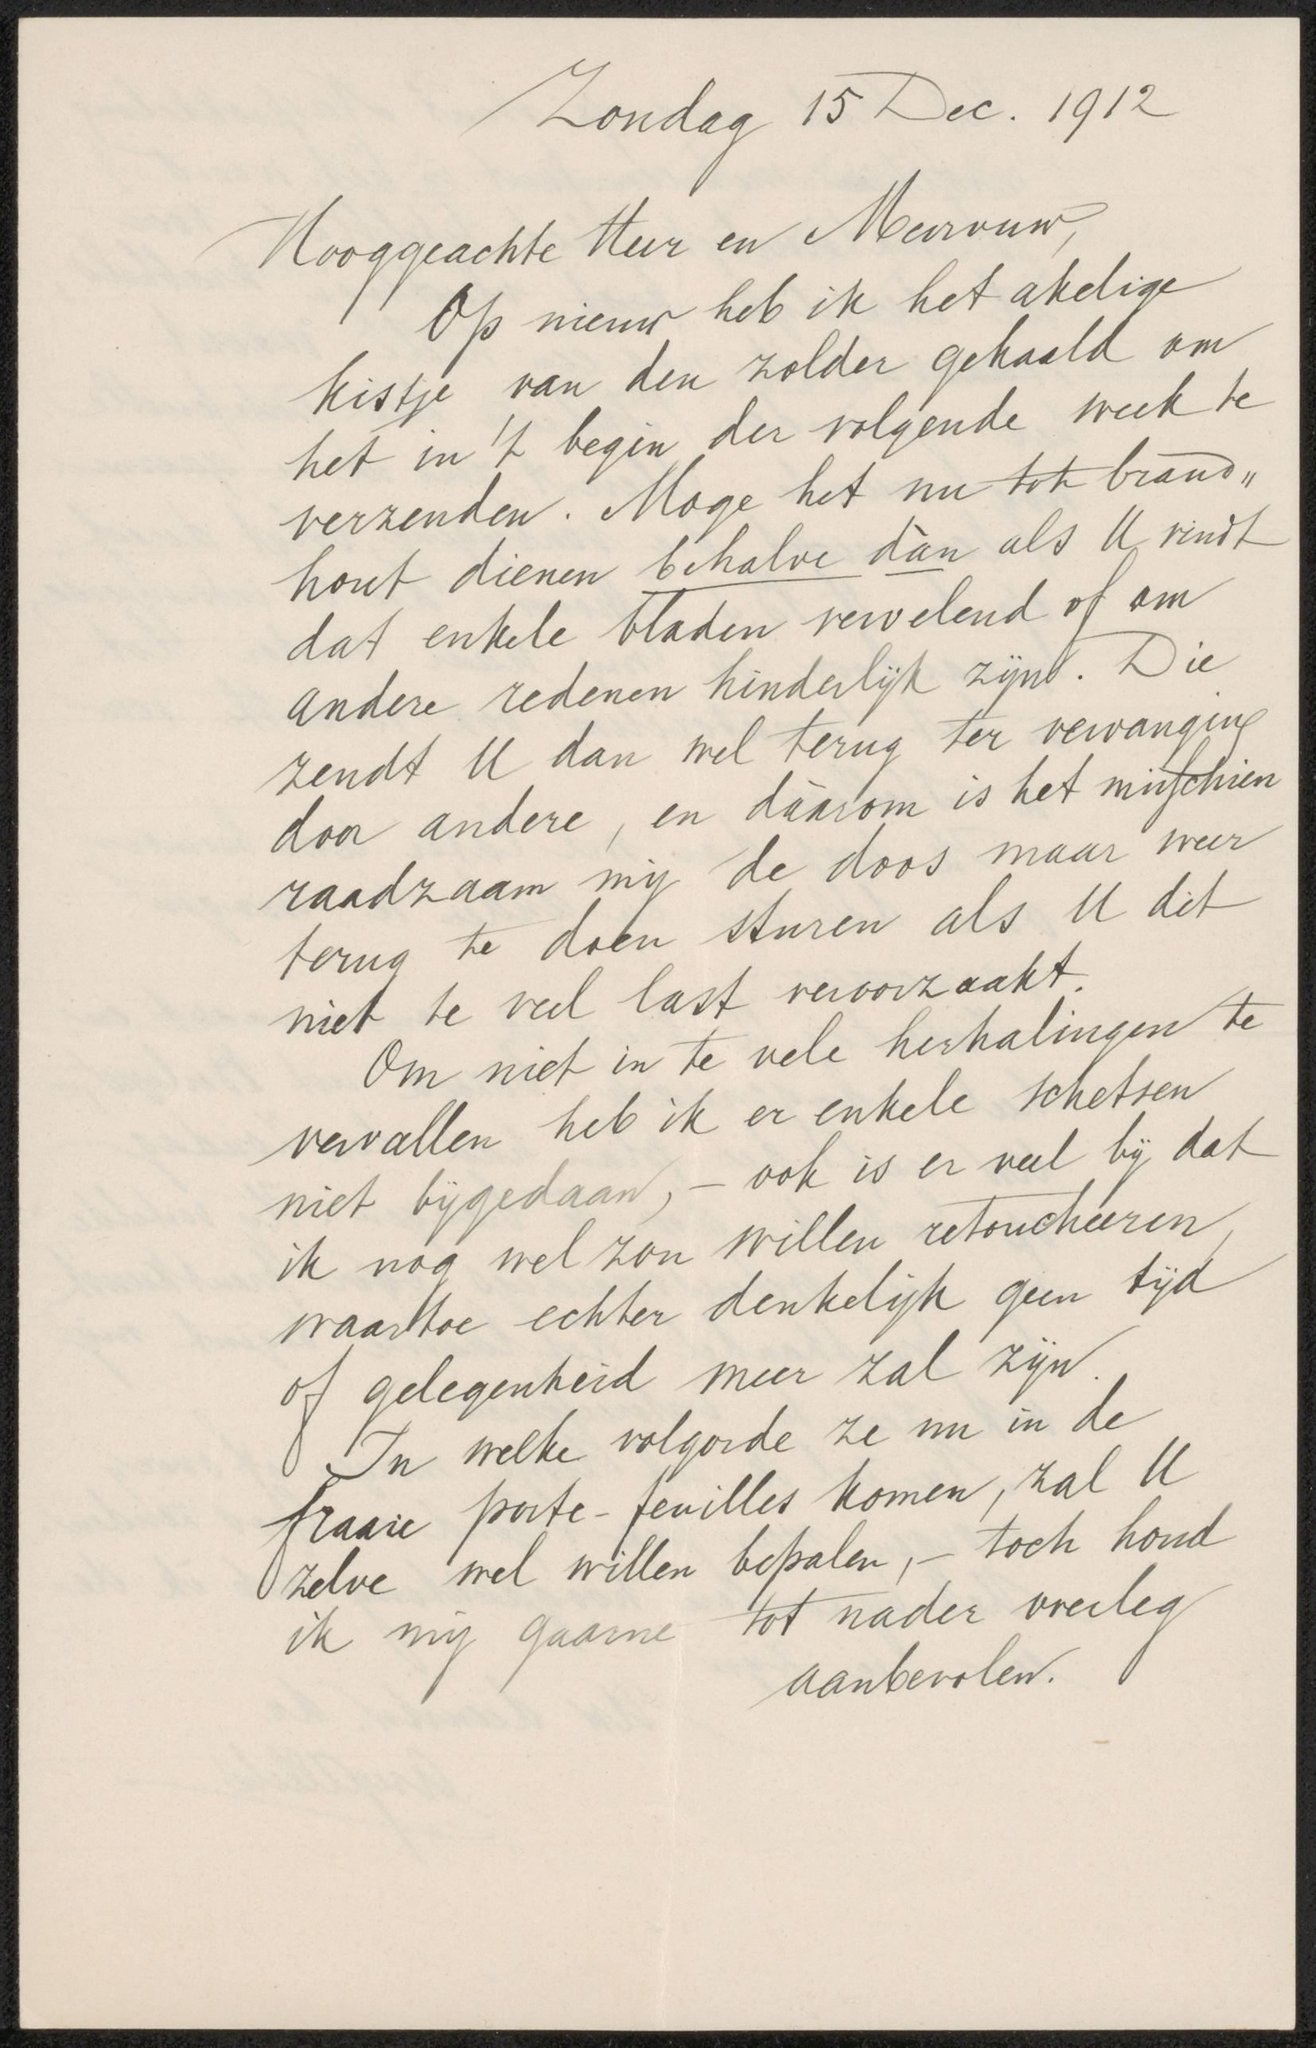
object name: letter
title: Brief aan Max Wilhelm Carl Weber en Anne Antoinette Weber-Van Bosse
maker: august allebé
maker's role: draughtsman, print maker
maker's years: 1838-1927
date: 1912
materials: ink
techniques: pen, writing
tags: rotterdam, charles albert de burlet, amsterdam, anne antoinette weber-van bosse, art trade, art shop, drawing, the graphic arts